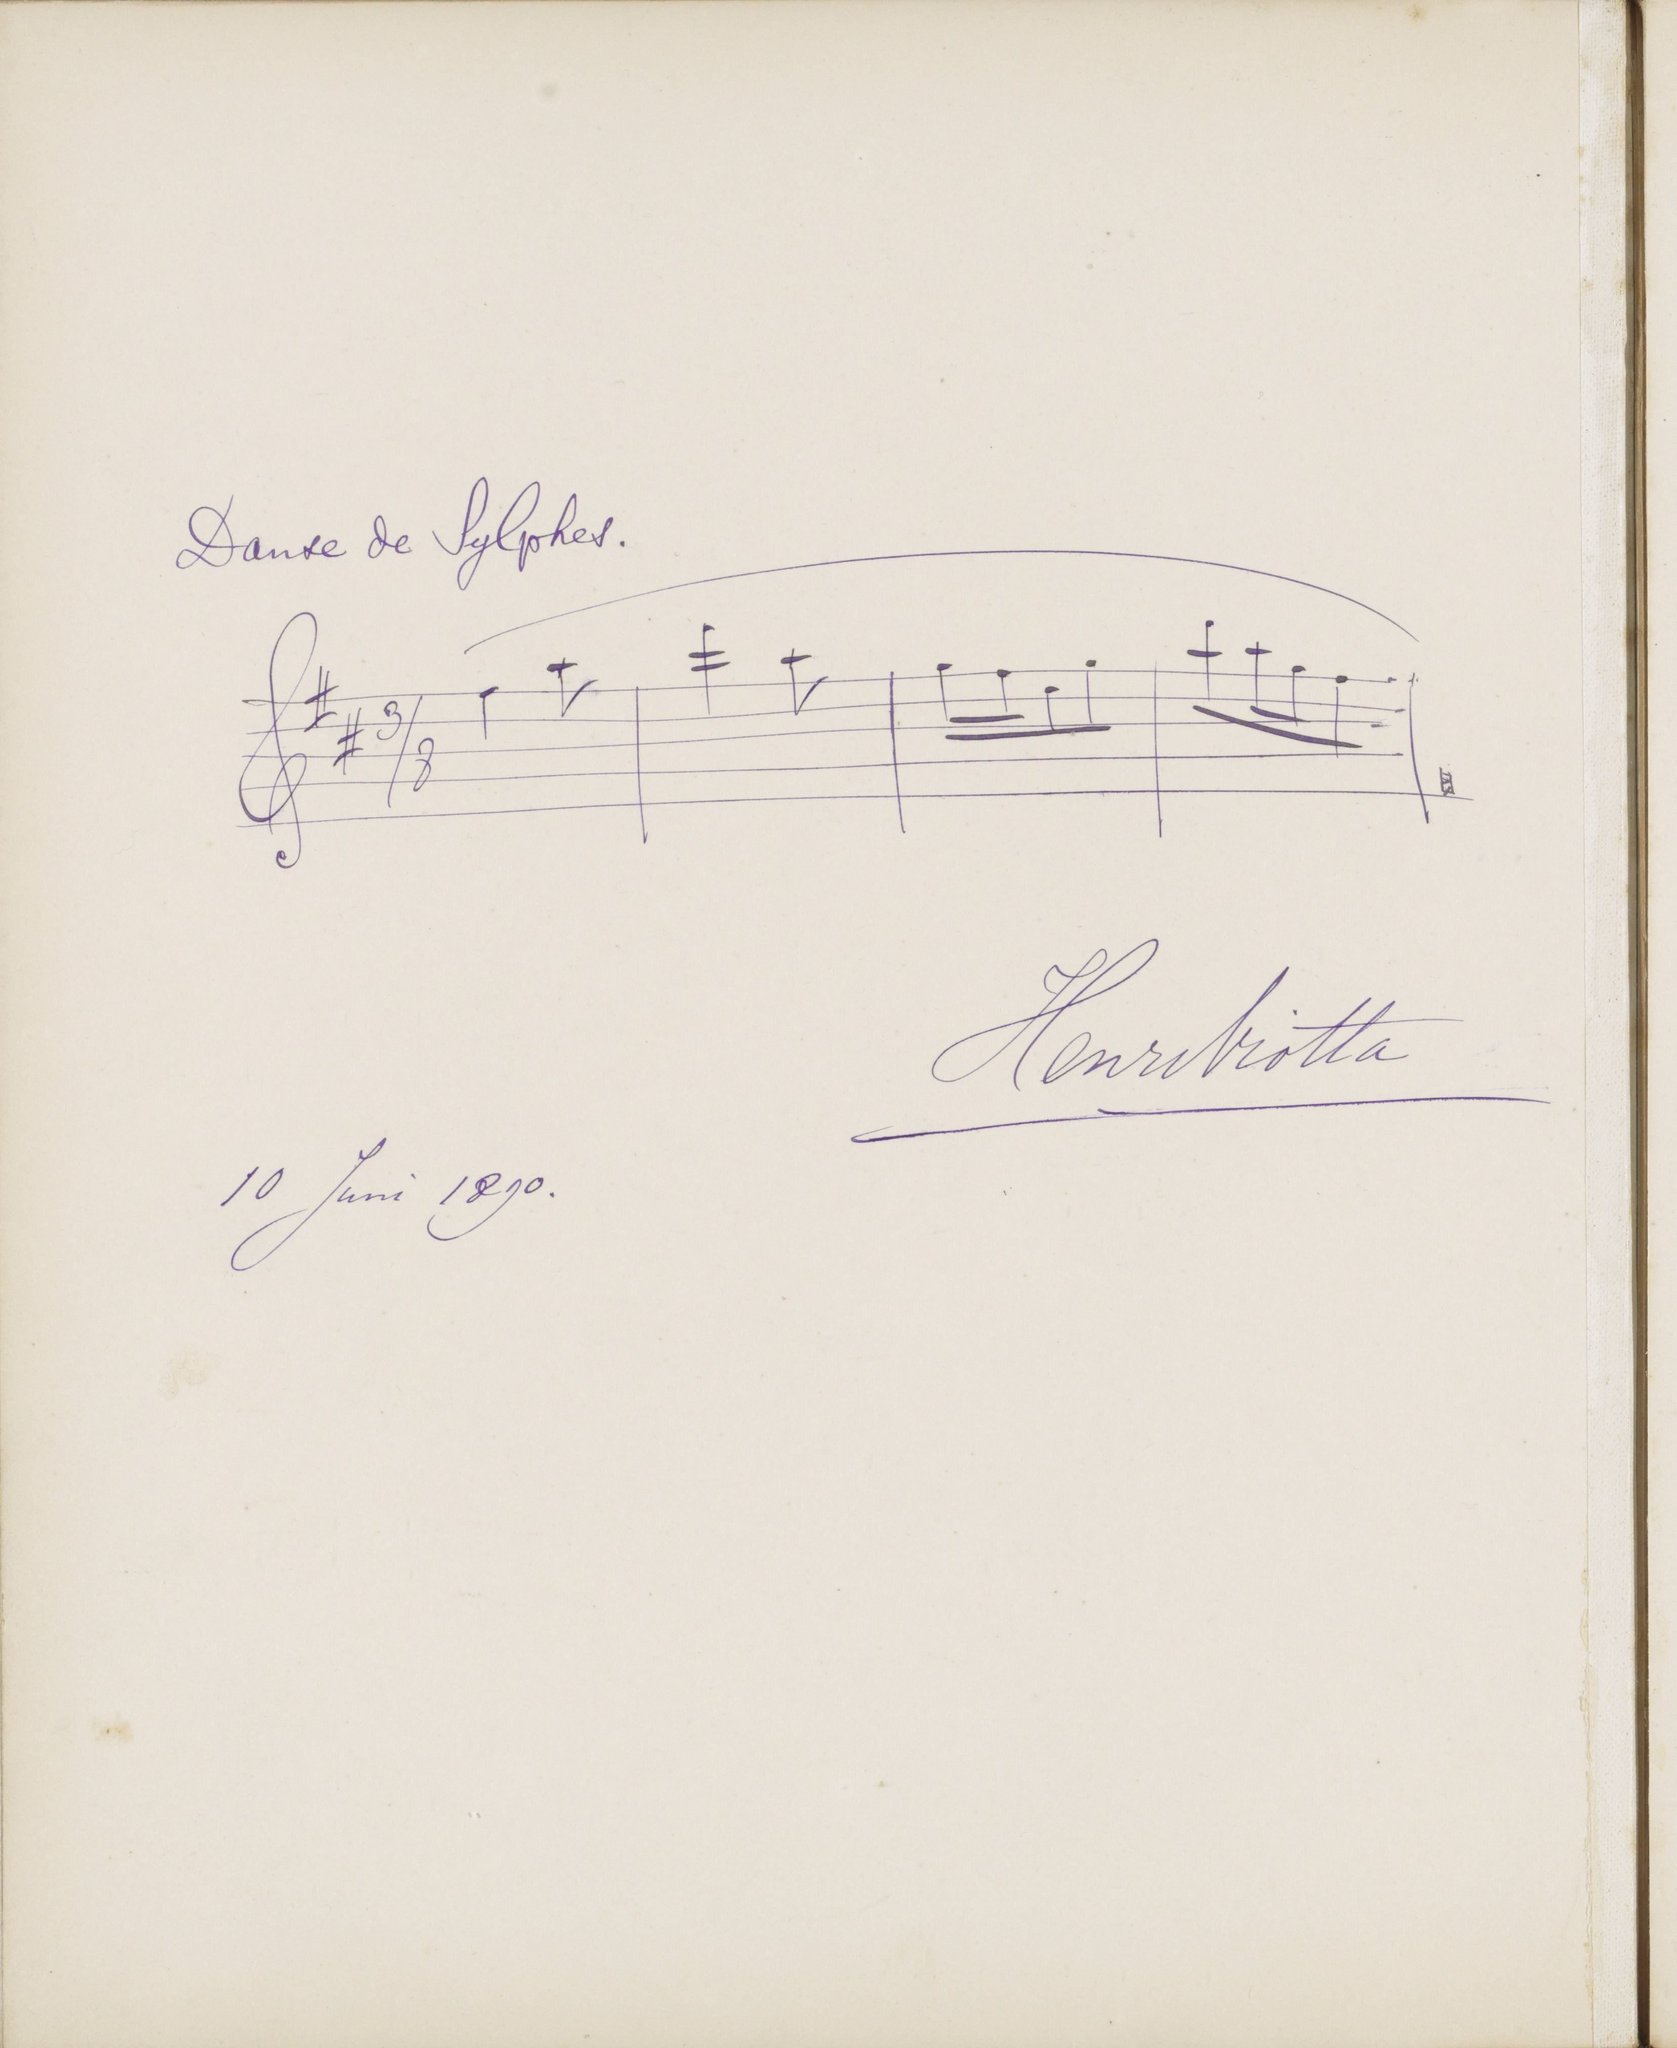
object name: album leaf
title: Getekende notenbalk voor P. Ankersmit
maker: Anonymous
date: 1806-1890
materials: ink, paper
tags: notation of music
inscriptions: date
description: Blad maakt deel uit van een album met ingeplakte tekeningen.